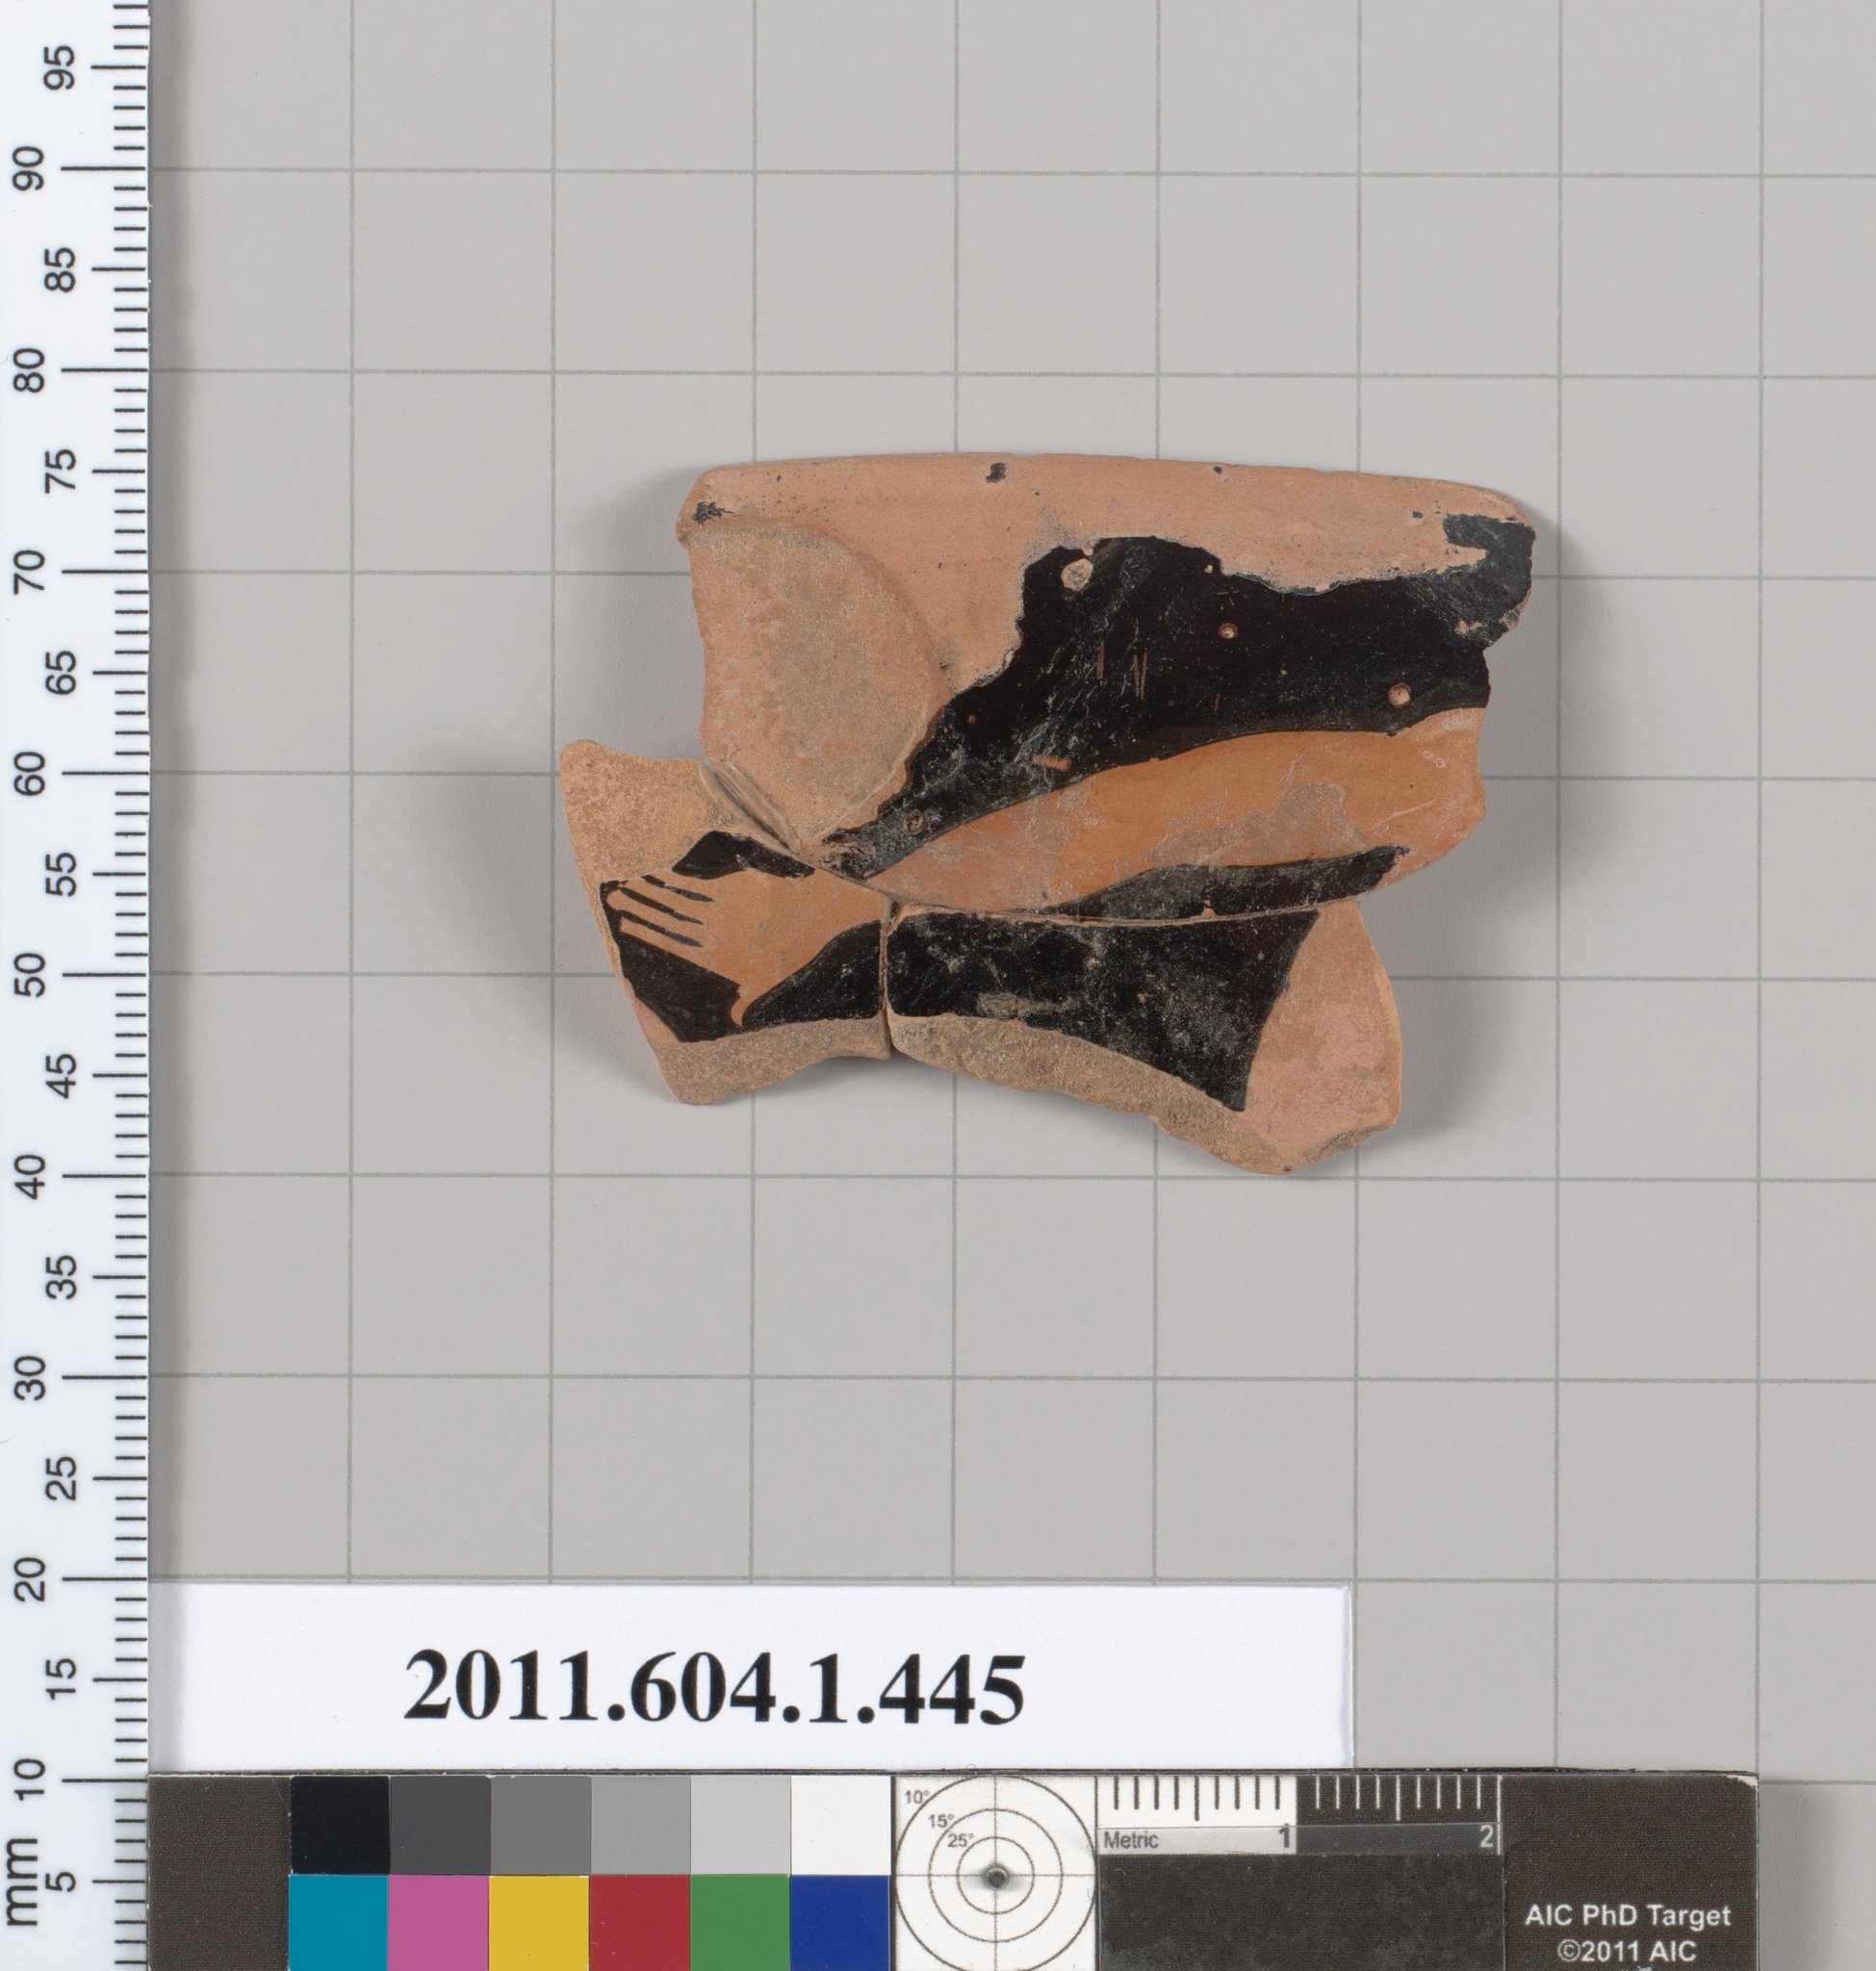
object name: kylix fragment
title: Terracotta rim fragment of a kylix (drinking cup)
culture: greek, attic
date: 475-451 BCE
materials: terracotta